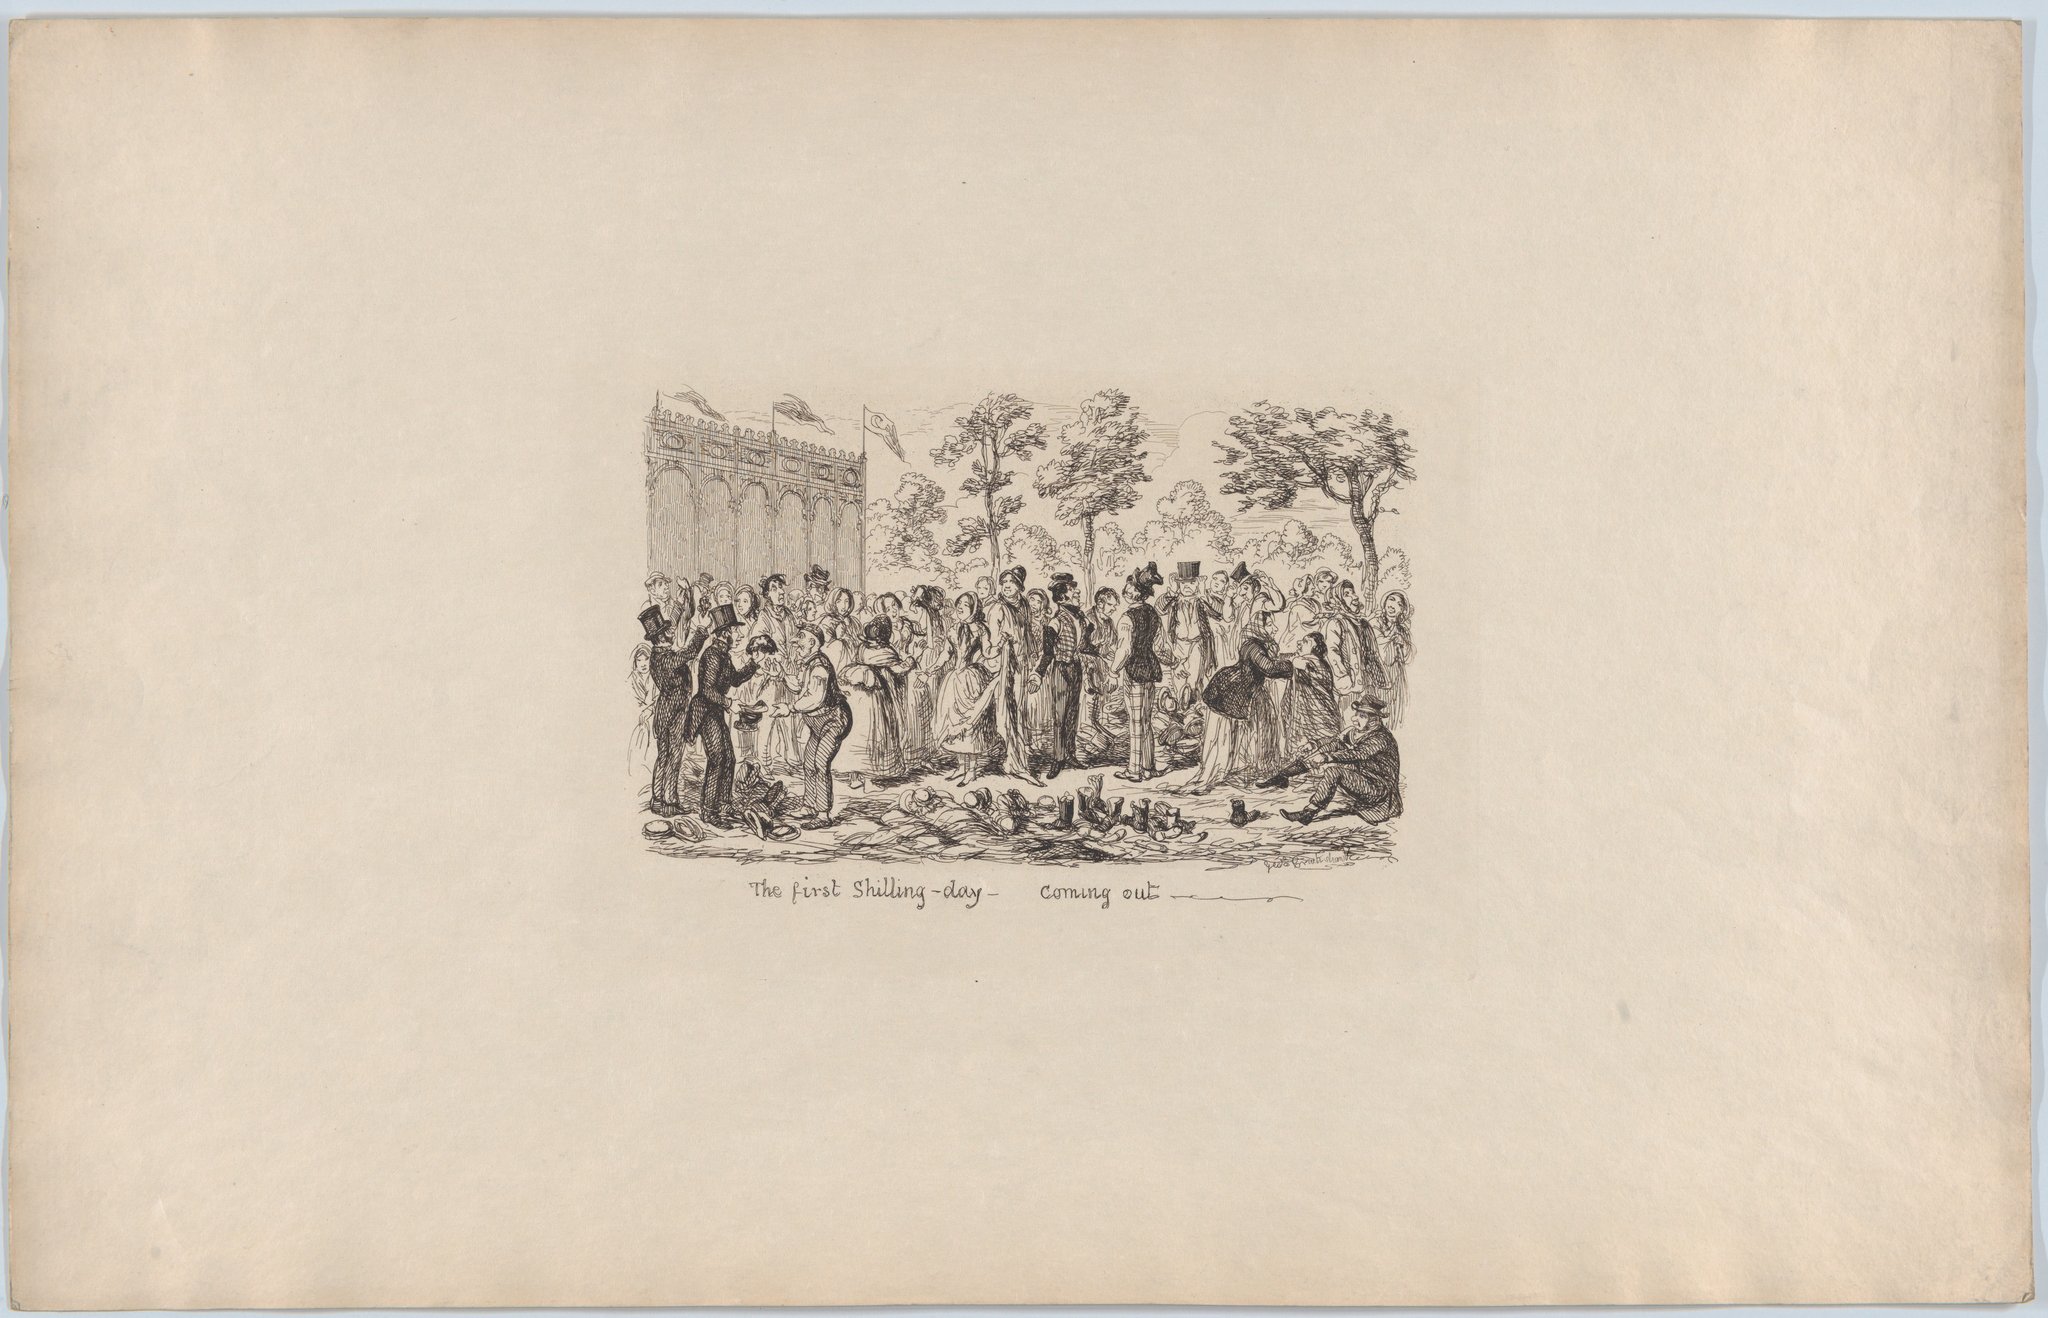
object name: print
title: The First Shilling Day–Coming Out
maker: george cruikshank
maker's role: artist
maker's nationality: british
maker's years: 1792-1878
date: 1851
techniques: etching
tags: men,women